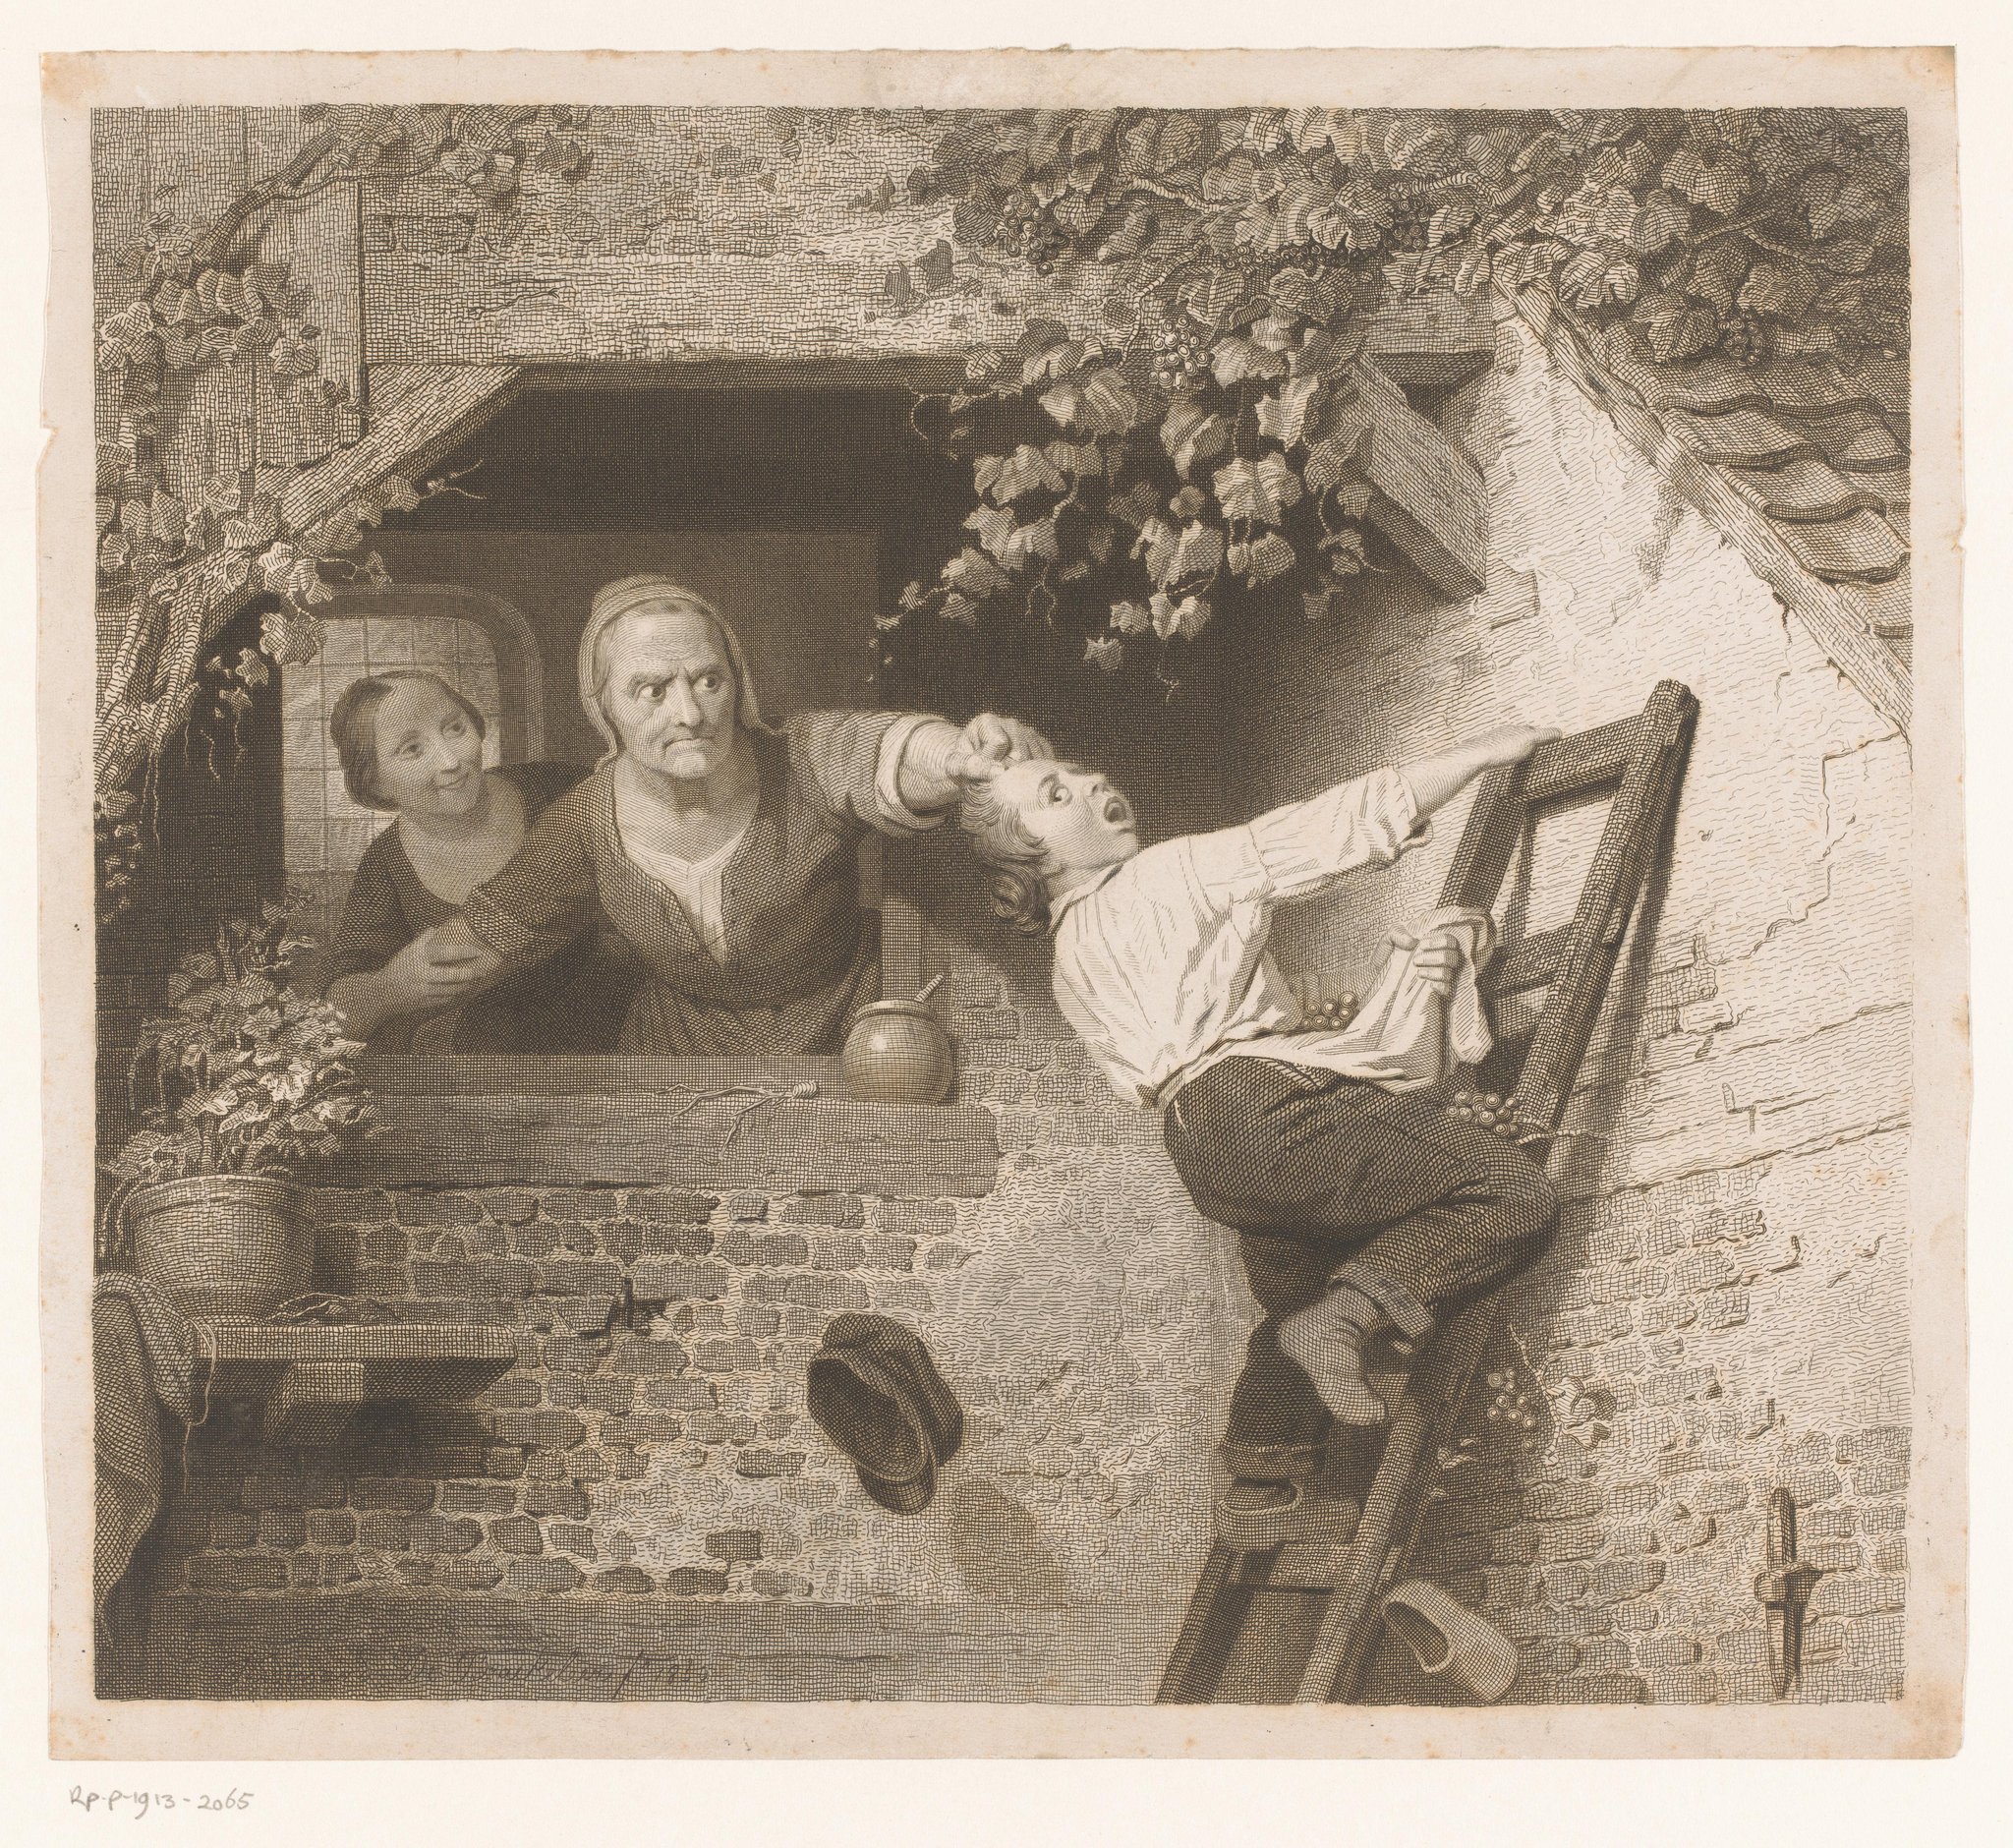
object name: print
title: Jongen op een ladder wordt betrapt op het stelen van druiven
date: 1850-1886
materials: paper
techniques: engraving, etching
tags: vine, thief, ladder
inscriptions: collector's mark: Lugt 2228